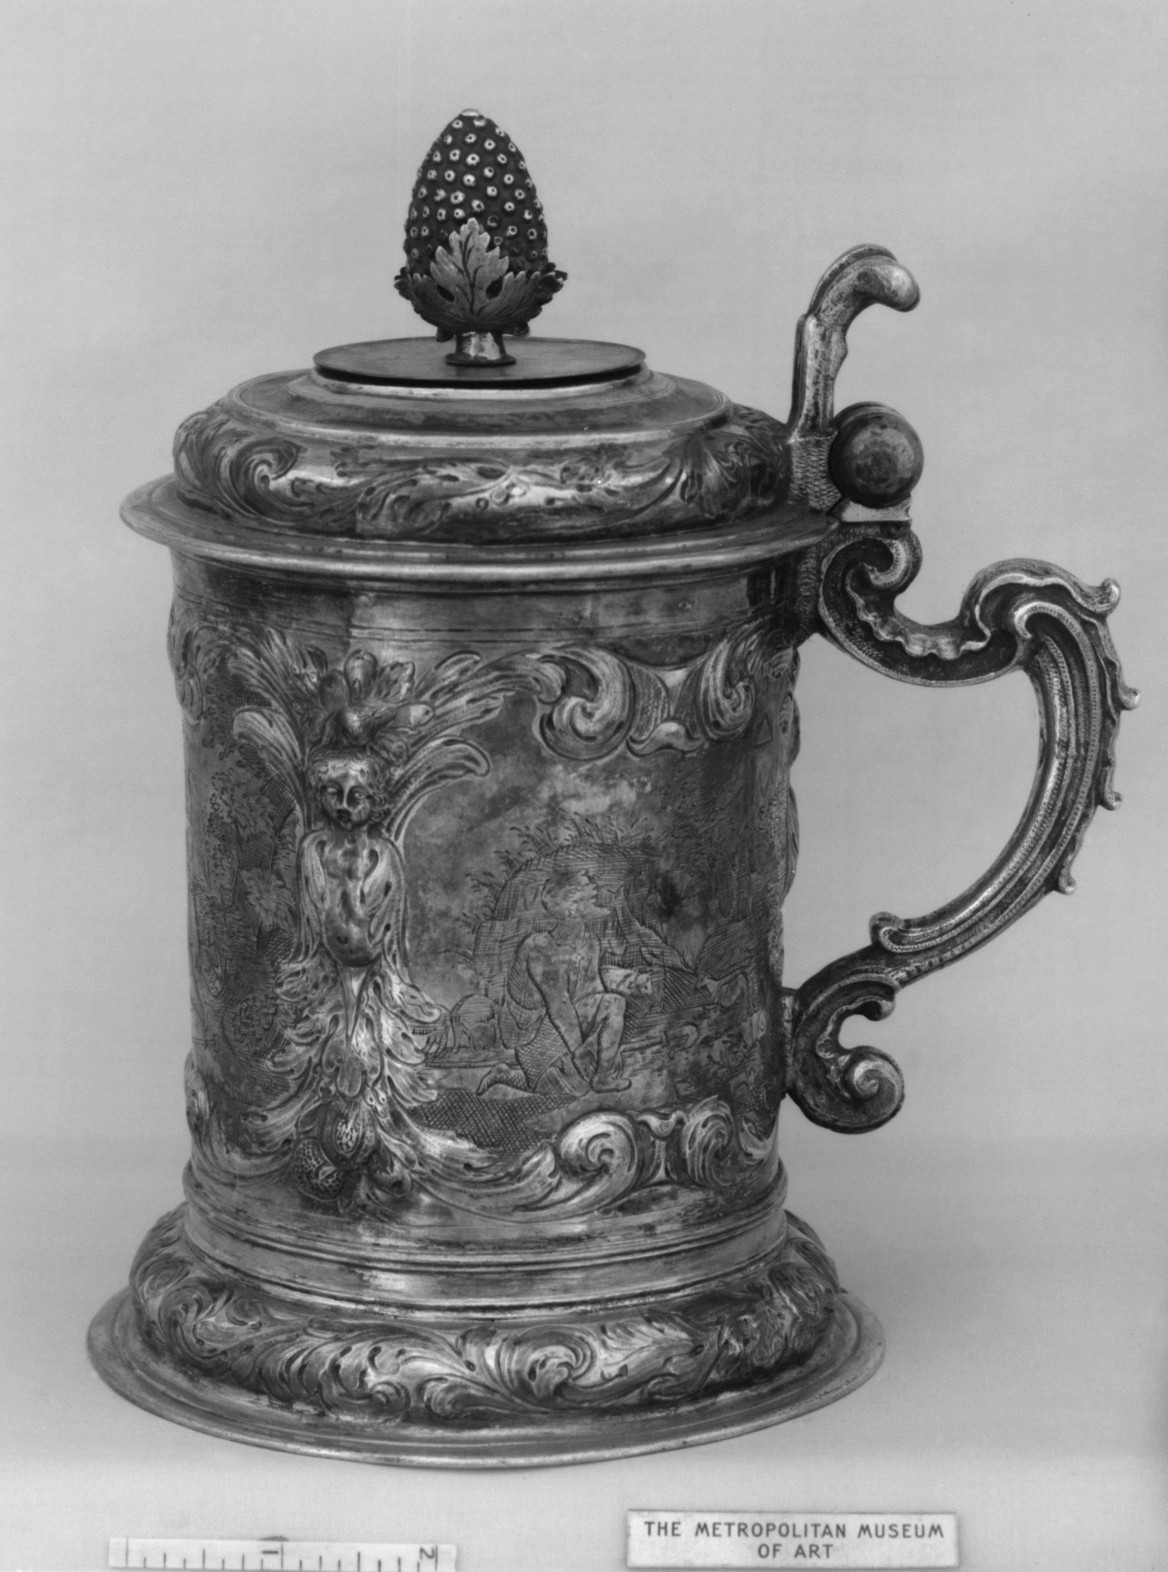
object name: tankard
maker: johann christian bierpfaf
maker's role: maker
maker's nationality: german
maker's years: 1620-1709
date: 1651-1700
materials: gilt, silver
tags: human figures,fruit